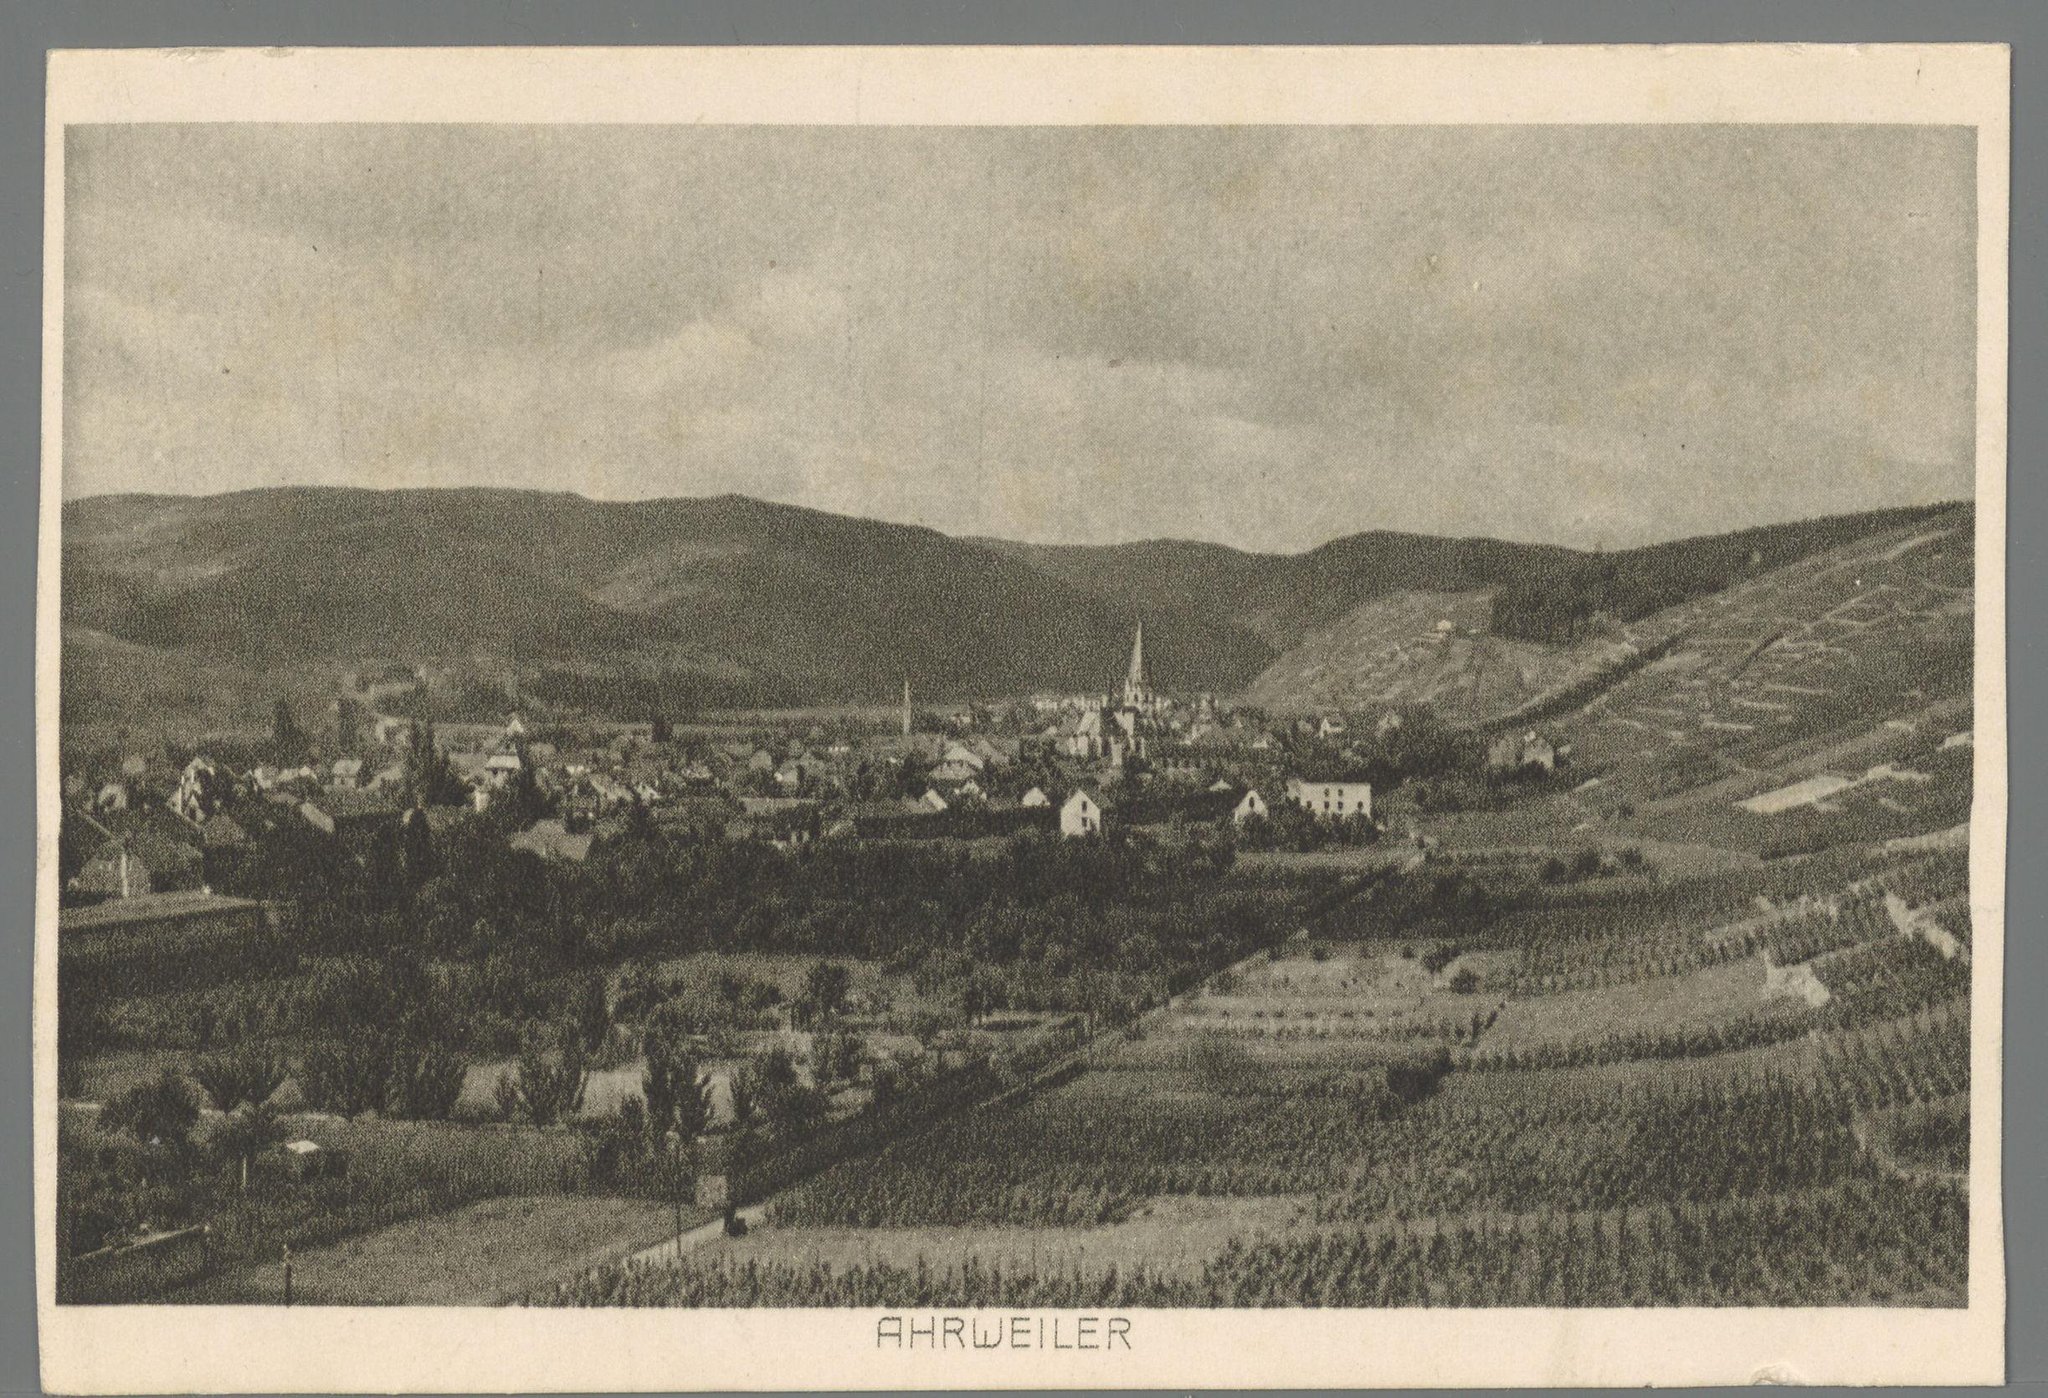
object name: photomechanical print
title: Ahrweiler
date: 1905-1930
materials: cardboard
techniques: rotogravure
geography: siegburg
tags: city-view, and landscape with man-made constructions, mountains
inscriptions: monogram: ‘K.T.F.’